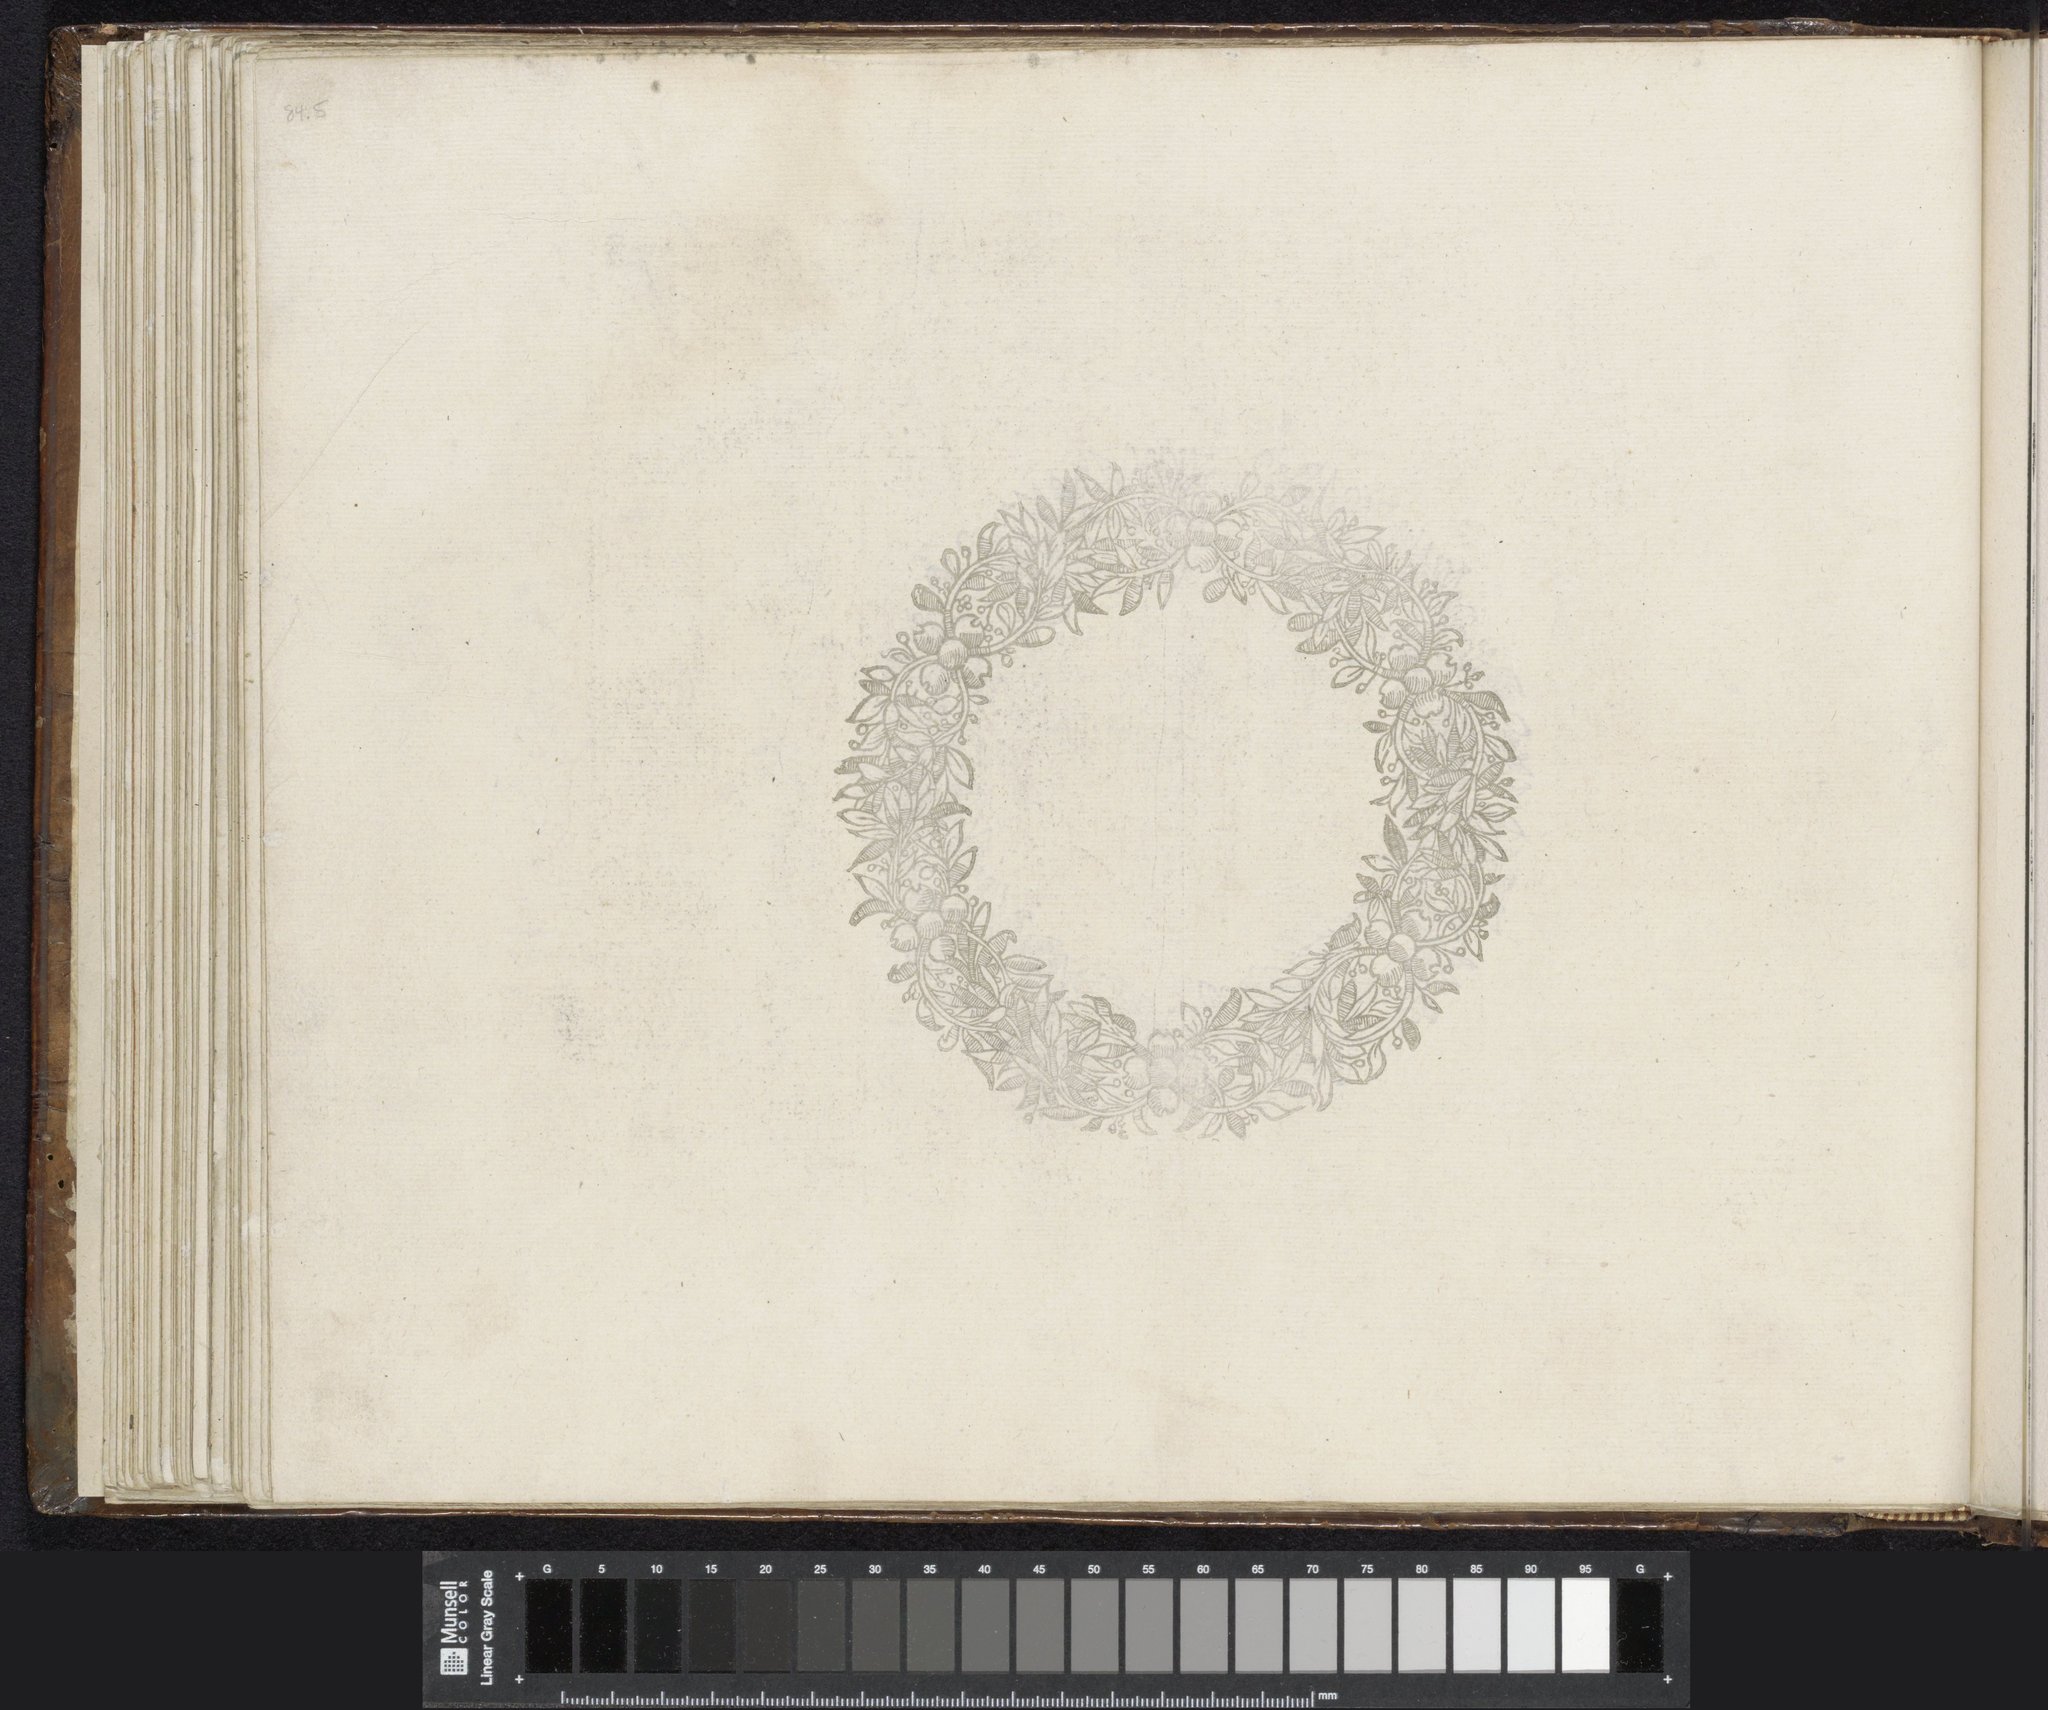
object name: album leaf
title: Ornamentele bloemenkrans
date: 1579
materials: paper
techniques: printmaking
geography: antwerp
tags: garland, wreath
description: Ornamentele bloemenkrans. Prent maakt deel uit van een album.